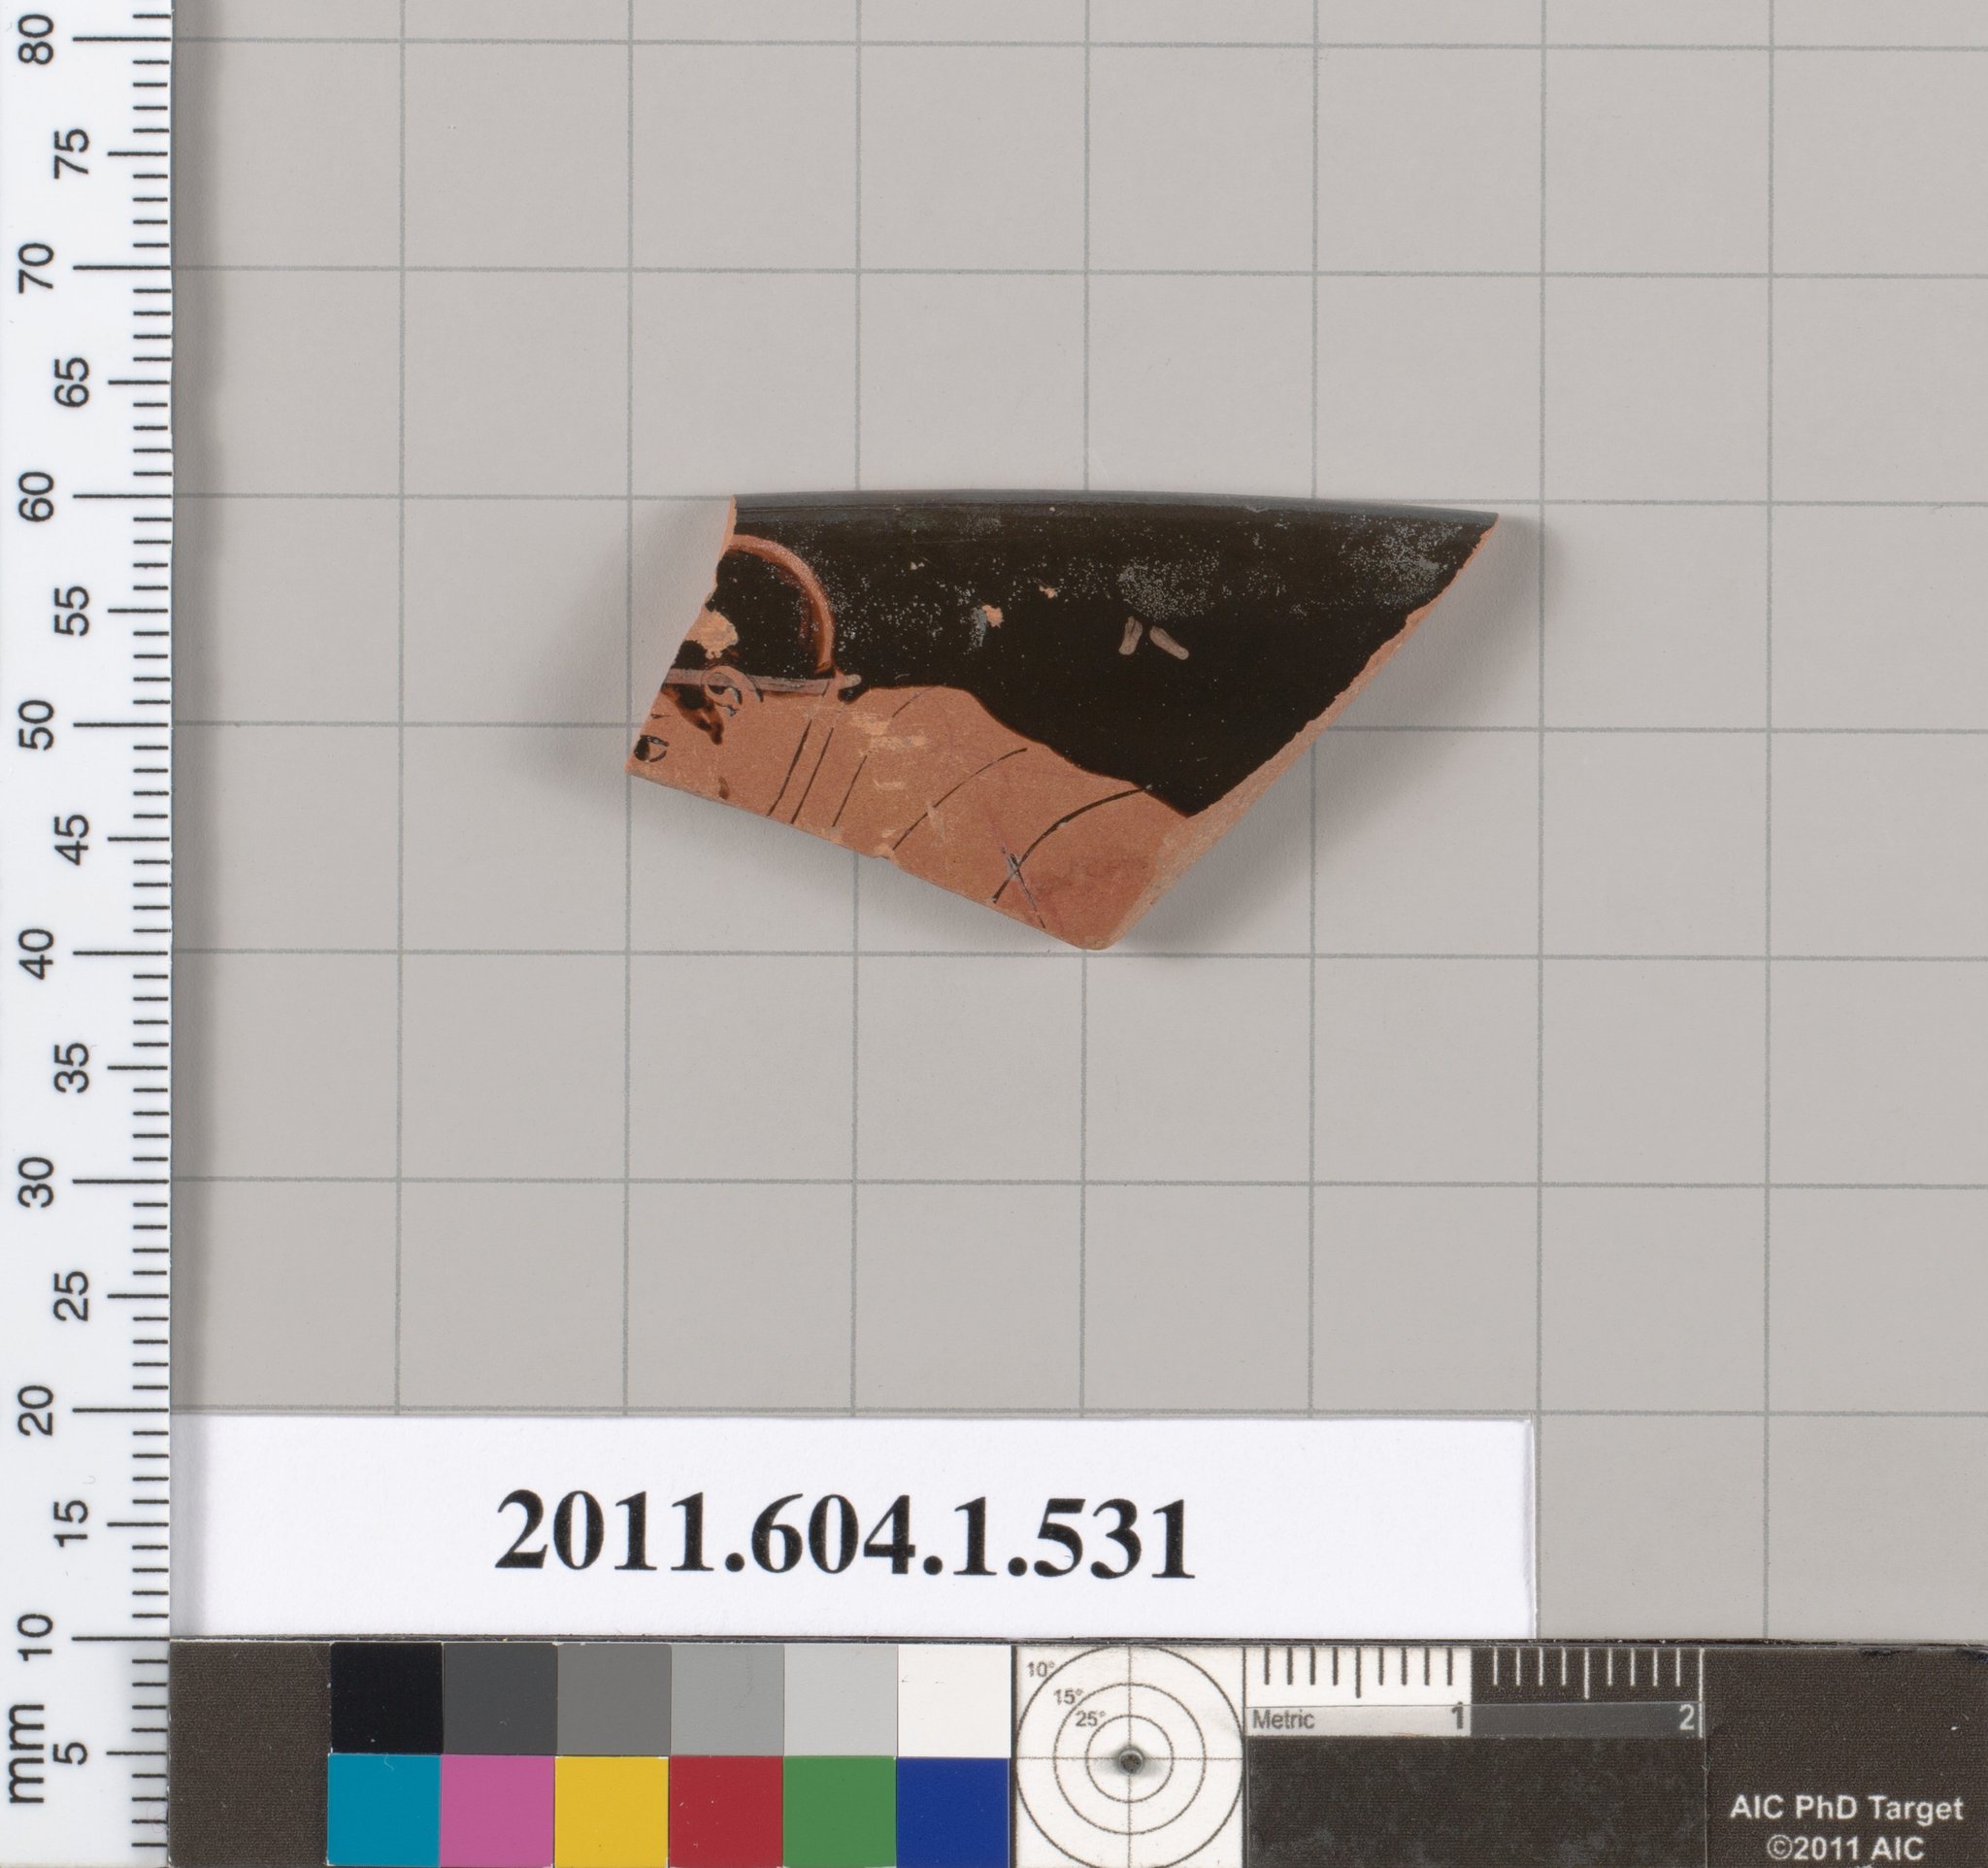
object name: kylix fragment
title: Terracotta rim fragment of a kylix (drinking cup)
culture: greek, attic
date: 480-470 BCE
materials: terracotta